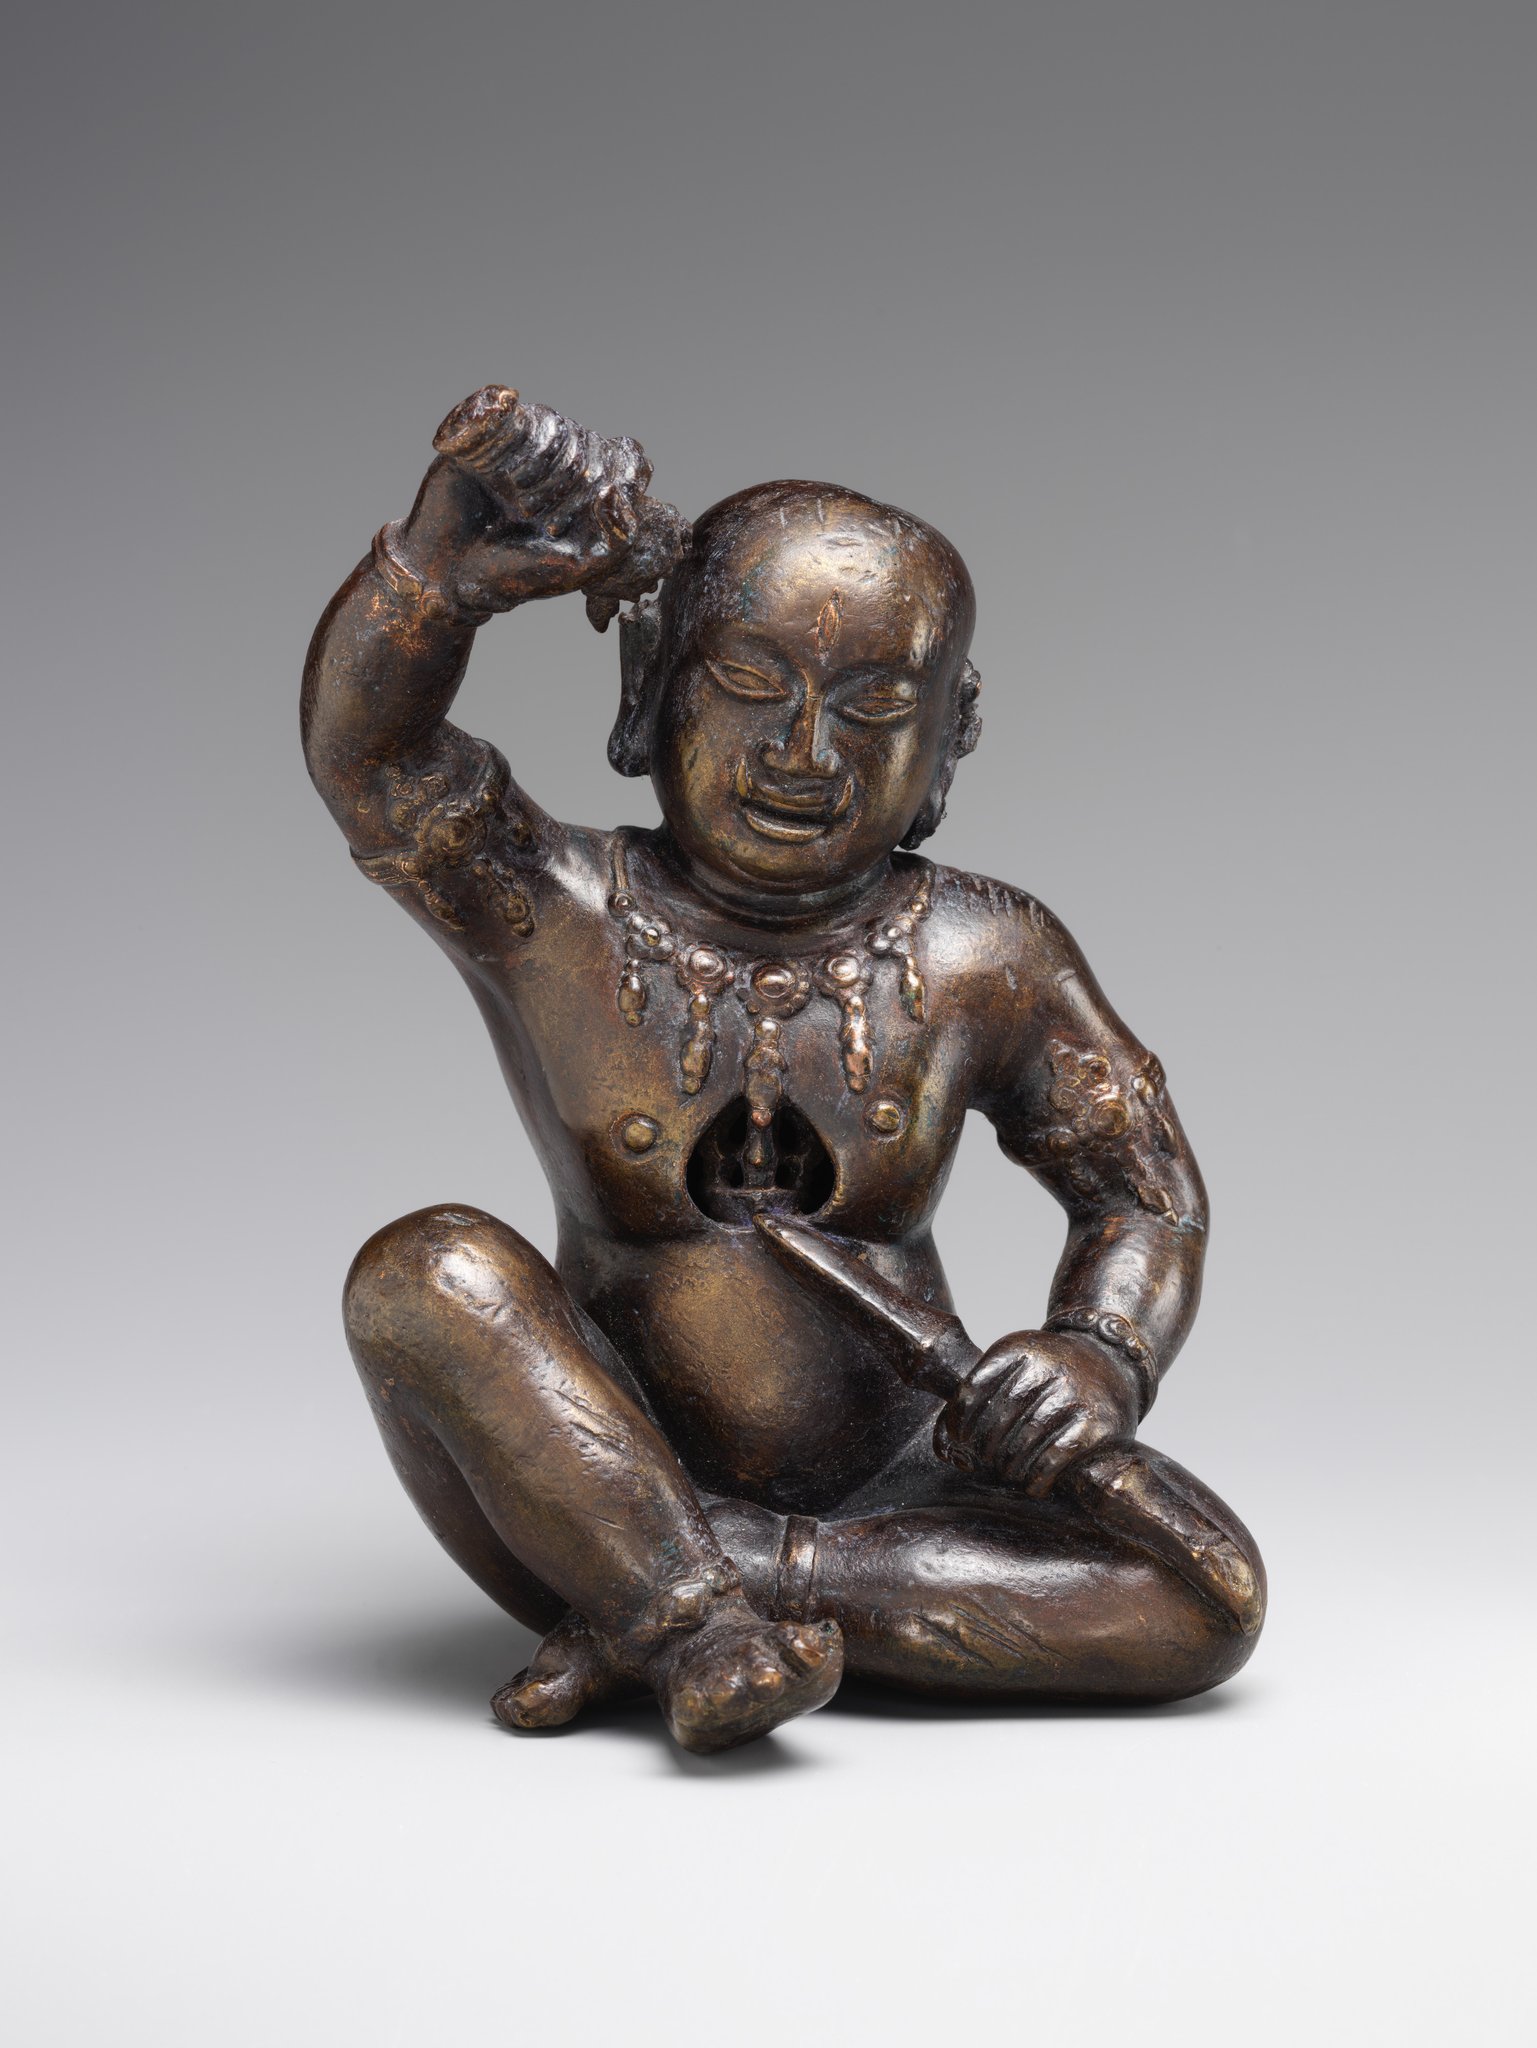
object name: figure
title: Esoteric Personification of the Vajra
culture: nepali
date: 1401-1500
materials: copper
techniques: gilding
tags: men,buddhism